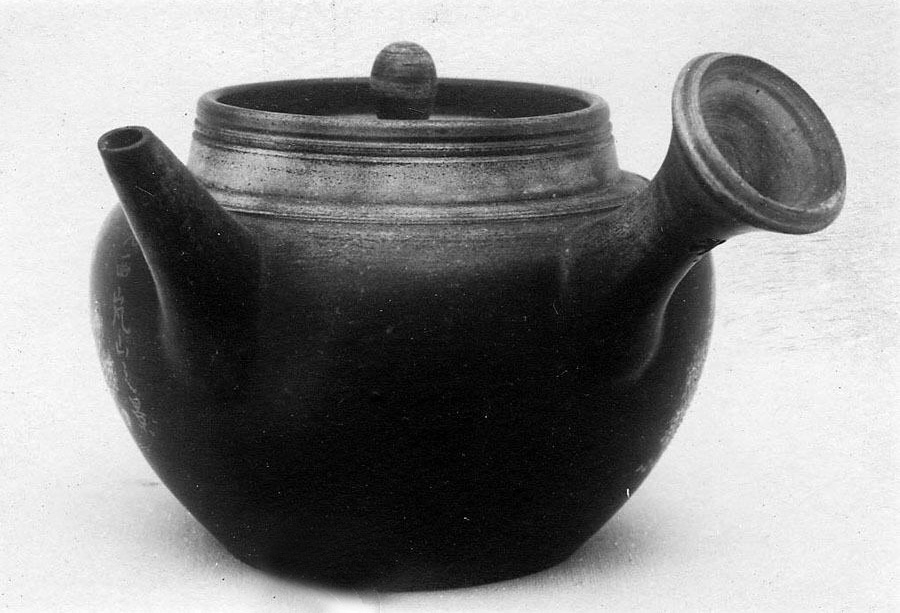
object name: teapot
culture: japanese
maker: rantei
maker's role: artist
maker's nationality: japanese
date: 1790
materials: clay, enamel, gold